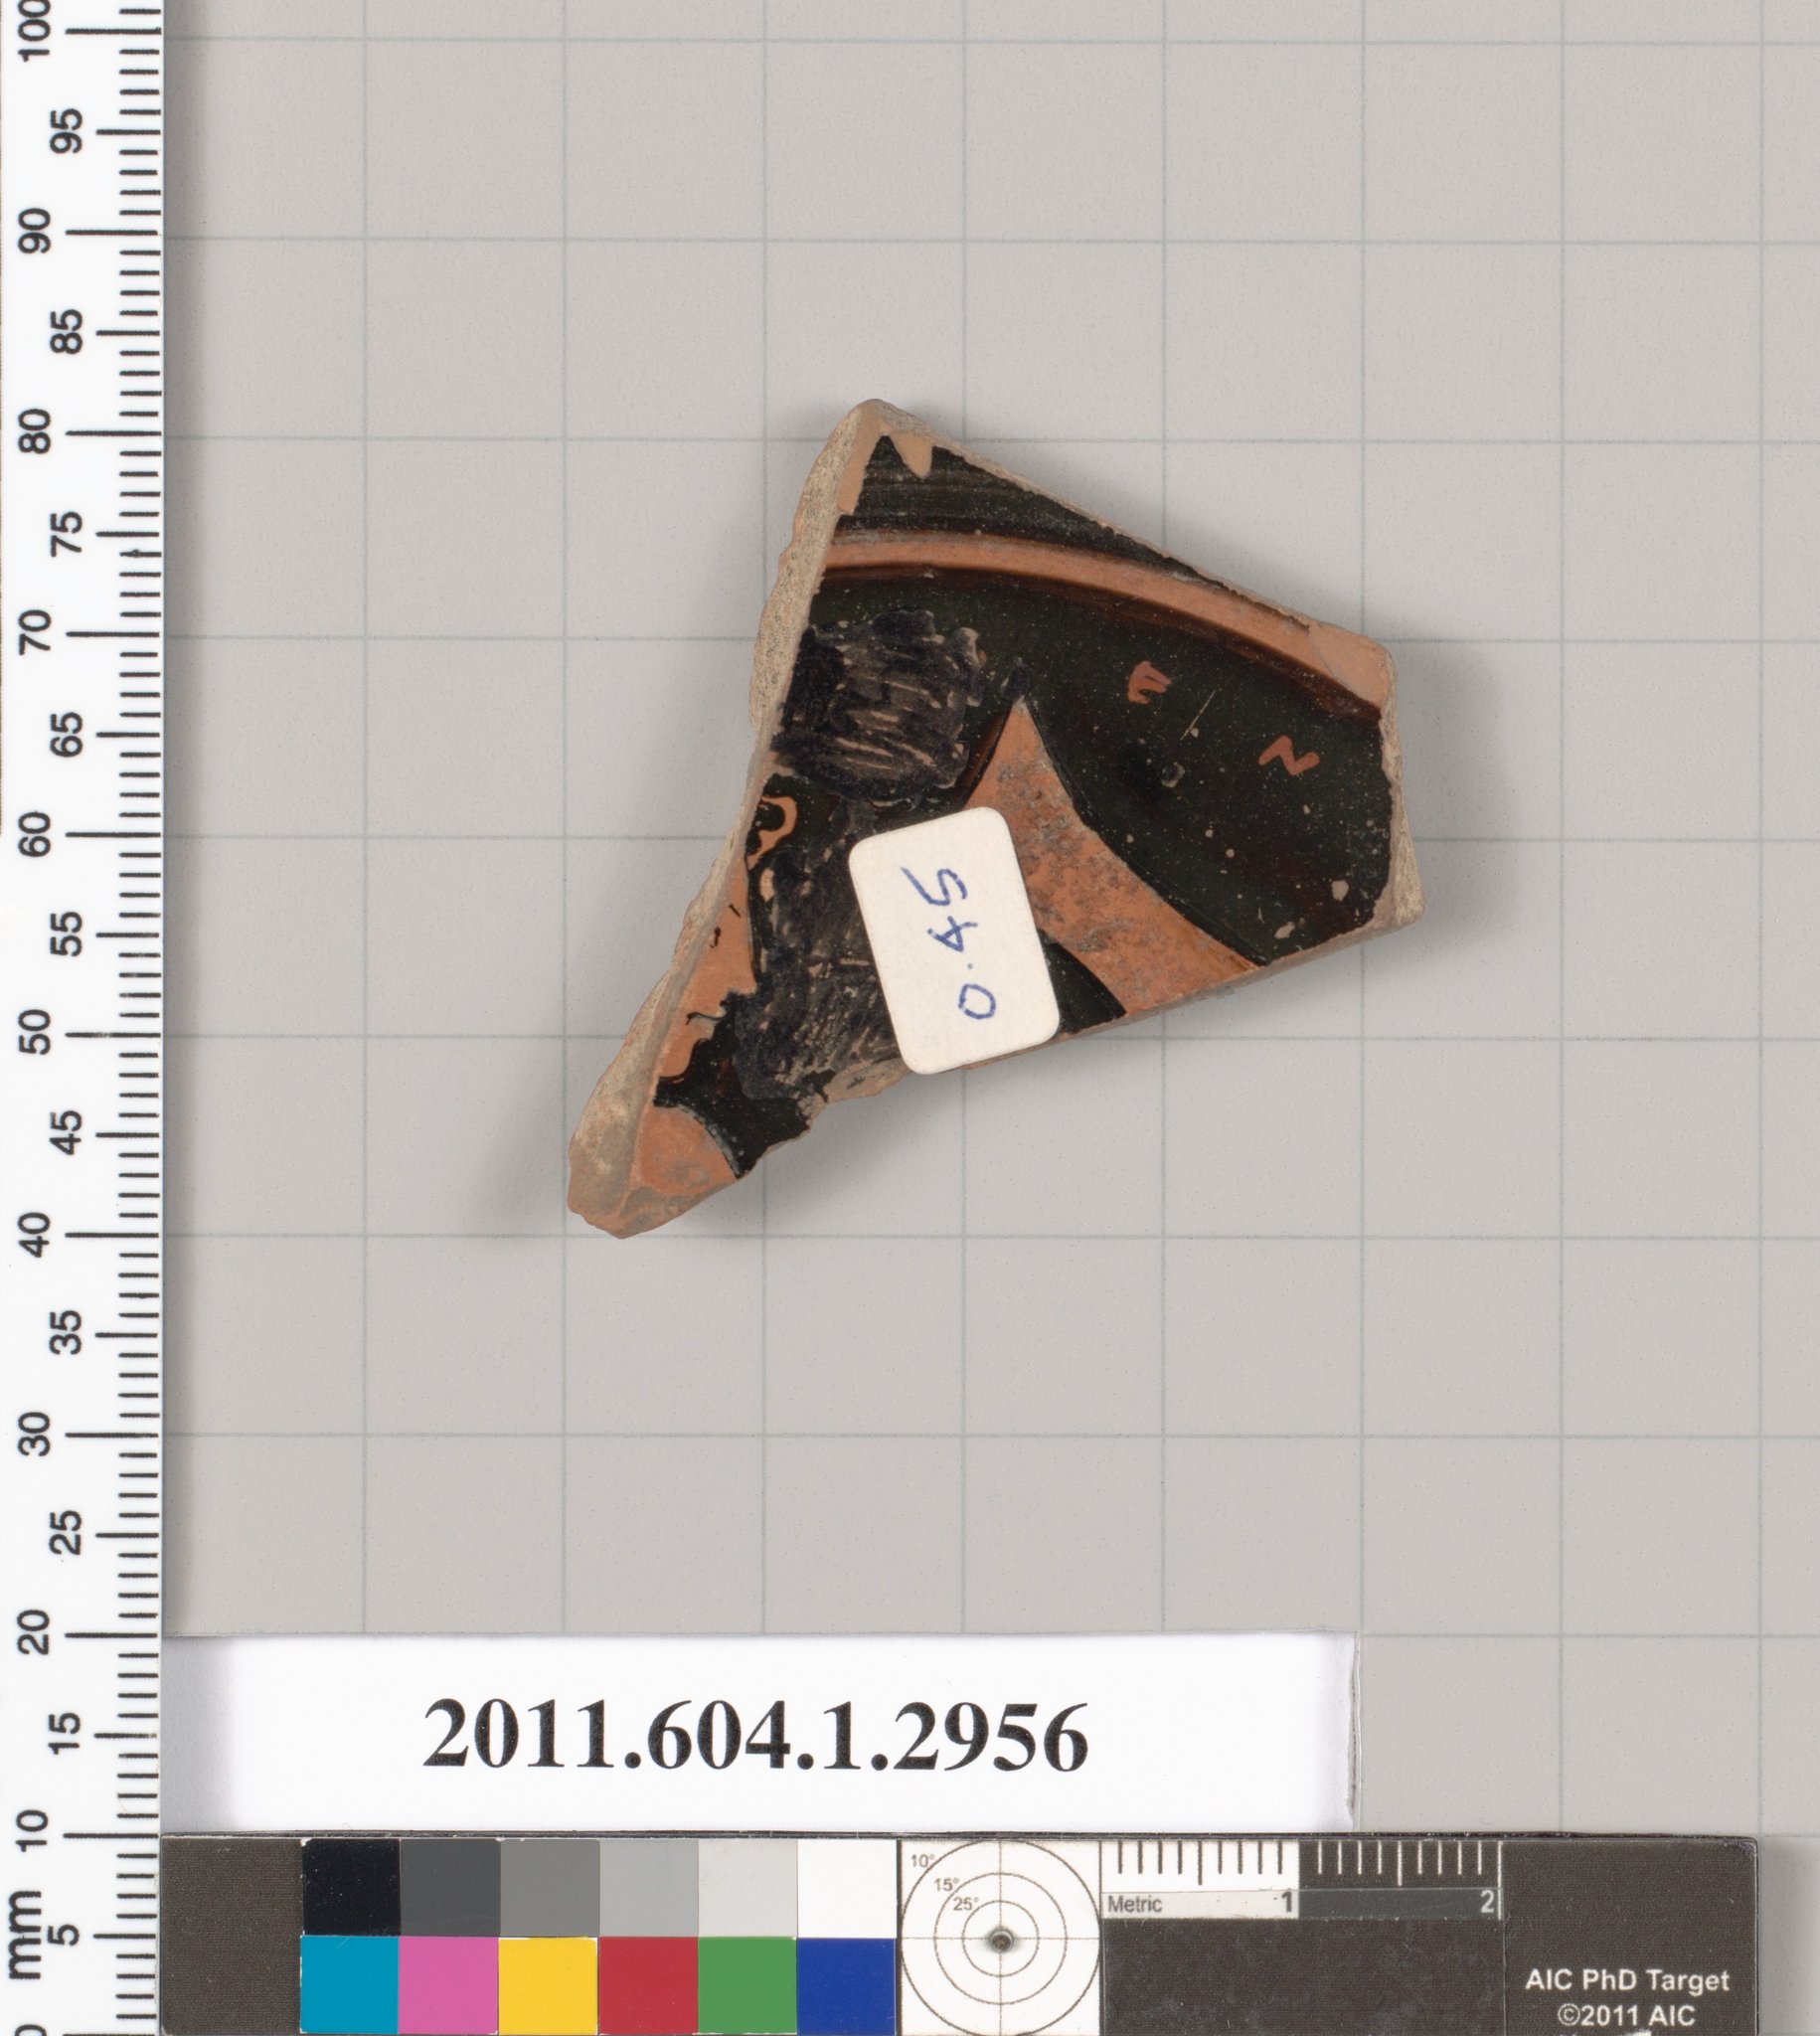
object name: kylix fragment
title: Terracotta fragment of a kylix (drinking cup)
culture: greek, attic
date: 490-470 BCE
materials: terracotta